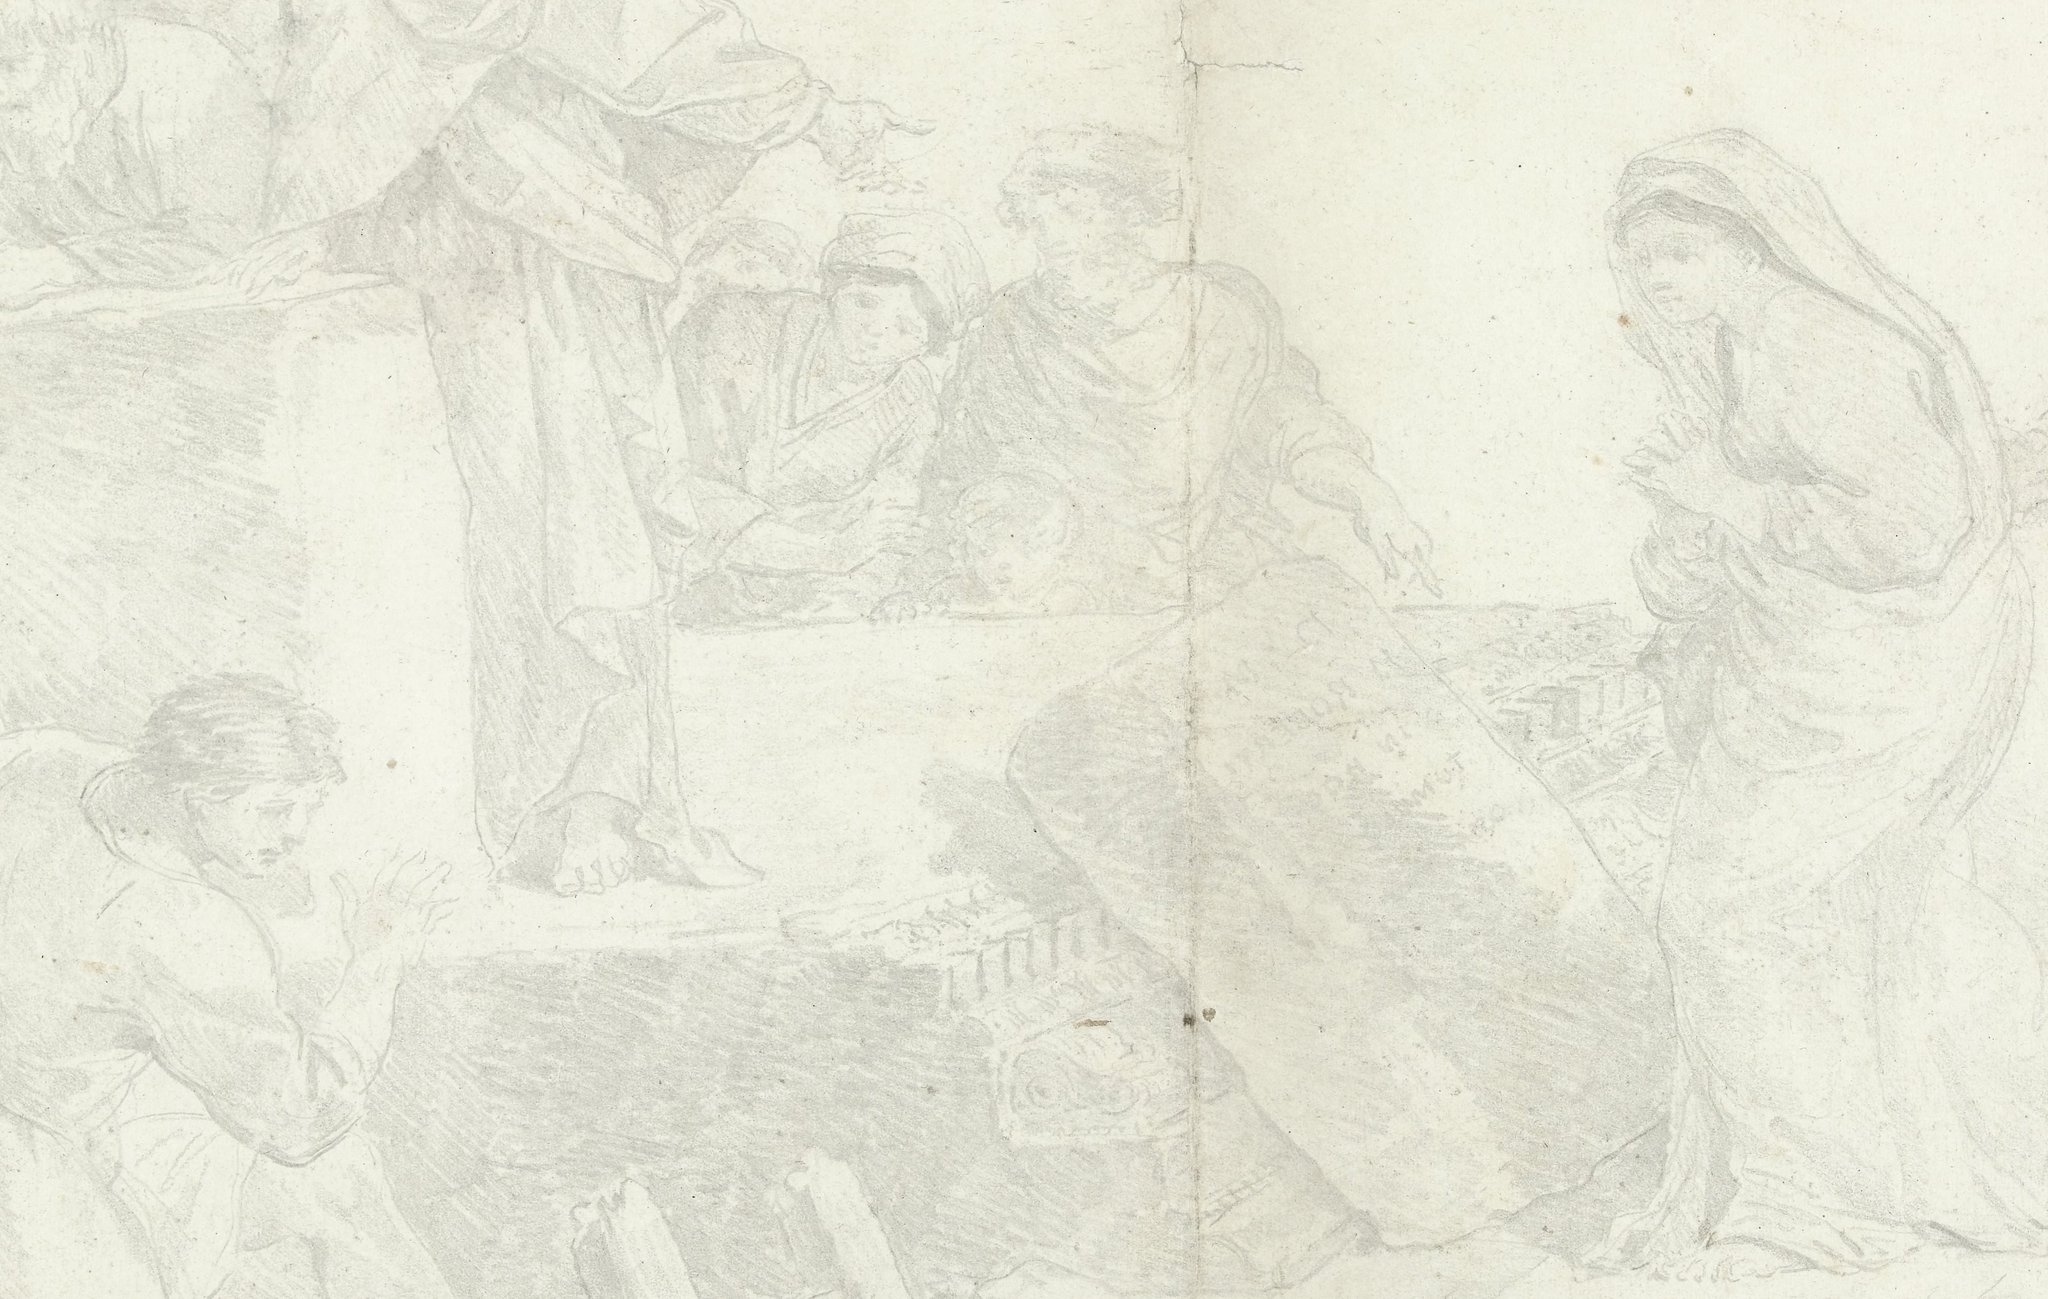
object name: drawing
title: De ontdekking van de grafsteen van Hubert Robert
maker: hubert robert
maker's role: draughtsman, print maker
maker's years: 1733-1808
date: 1743-1808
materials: chalk, paper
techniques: printmaking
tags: paris, print maker, draughtsman, hubert robert, gravestone, tombstone